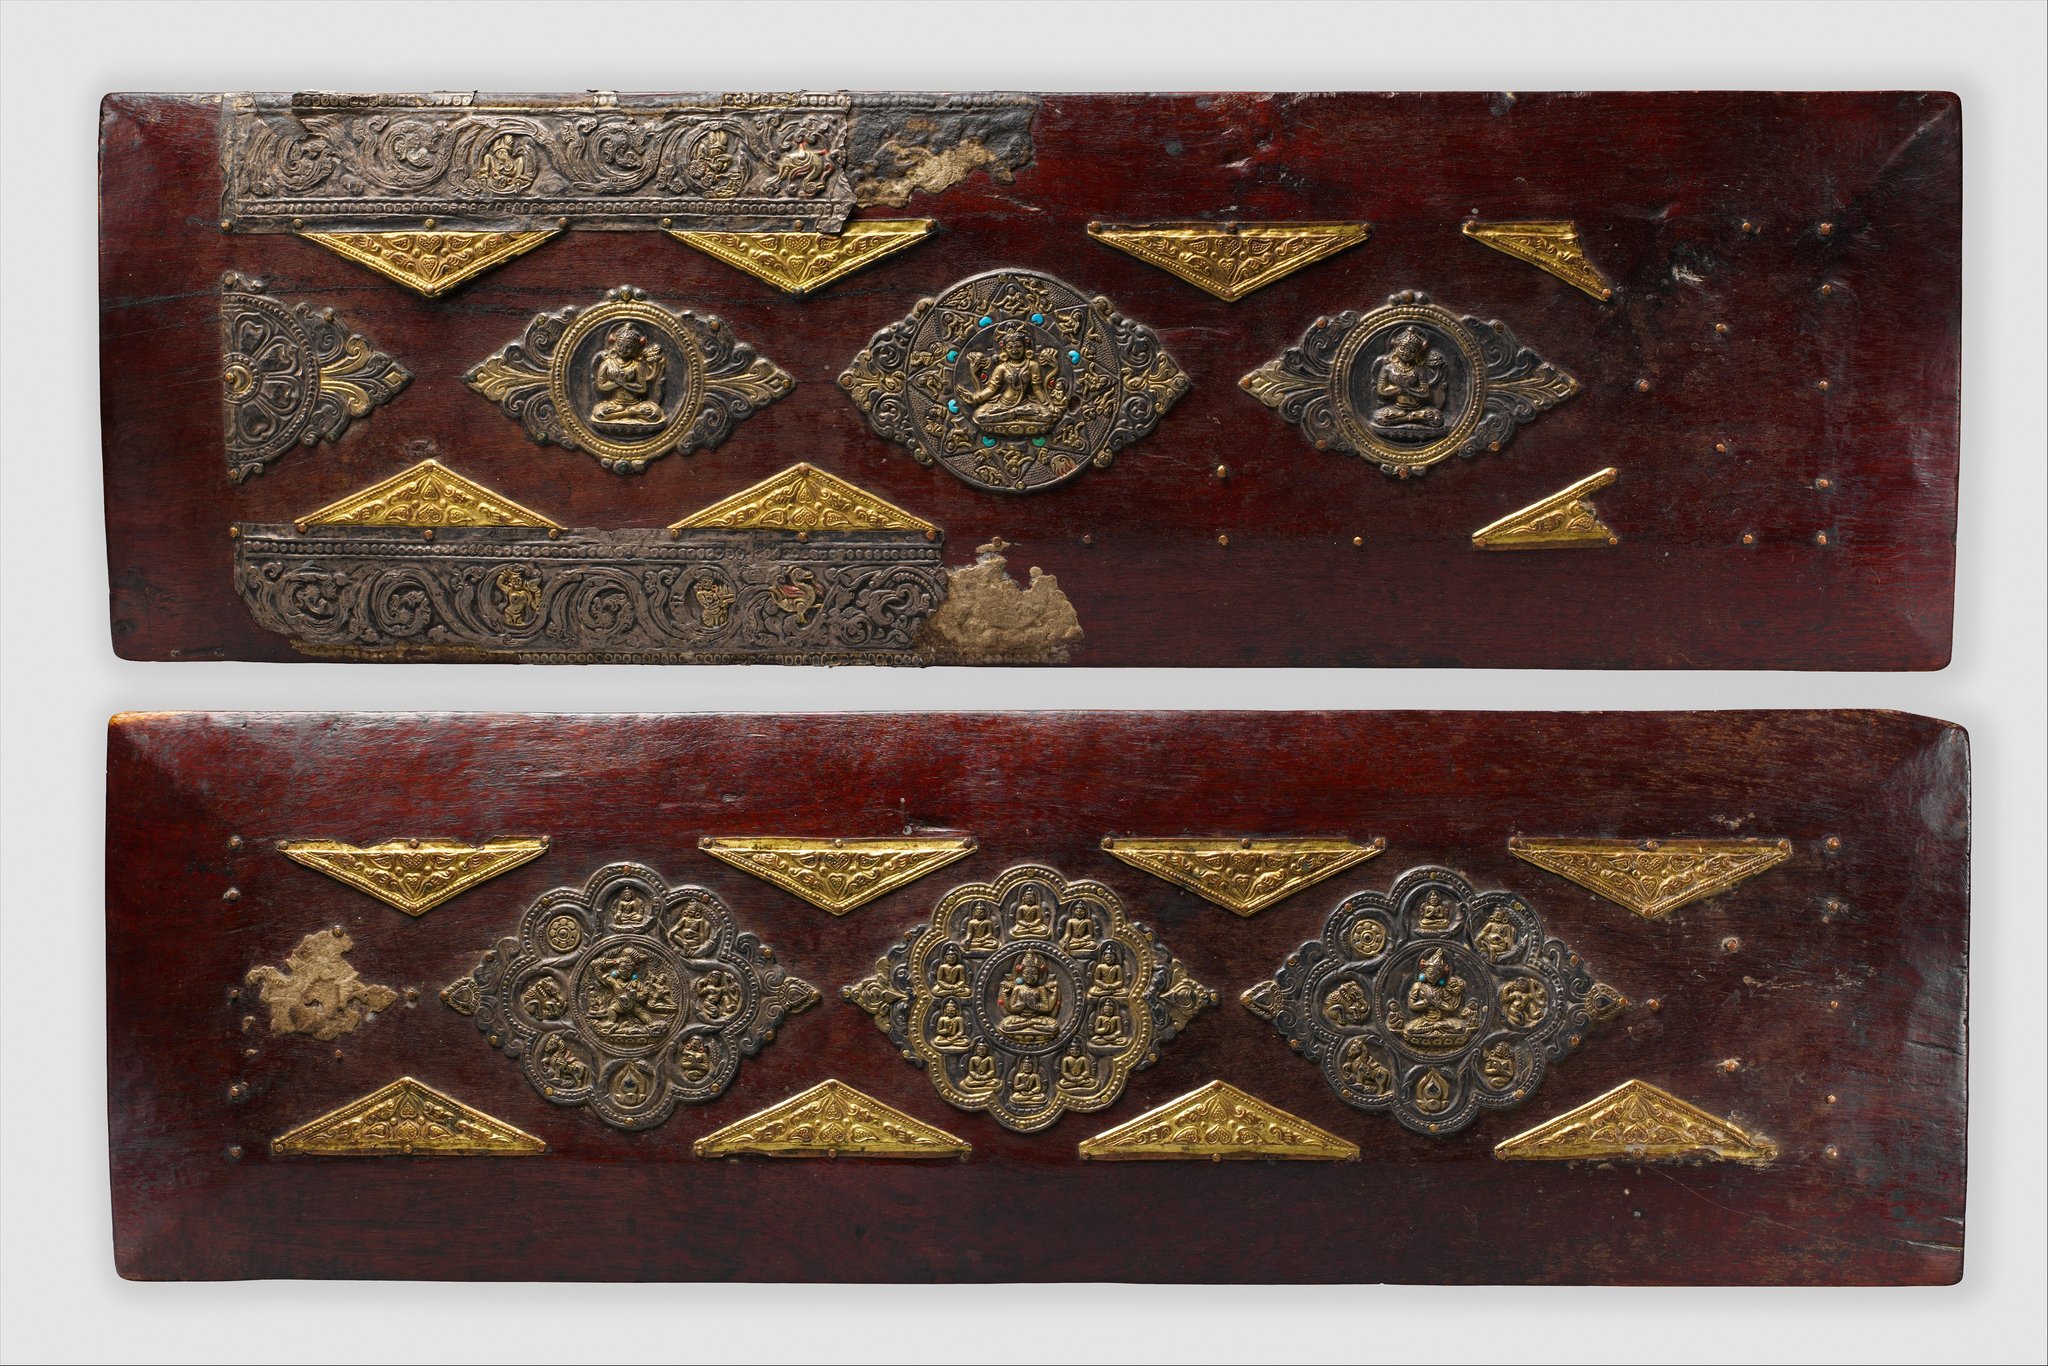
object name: book cover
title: Pair of Book Covers for a Buddhist Text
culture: india or tibet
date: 1101-1200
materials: copper alloy, gilt, paint, silver, stone, wood